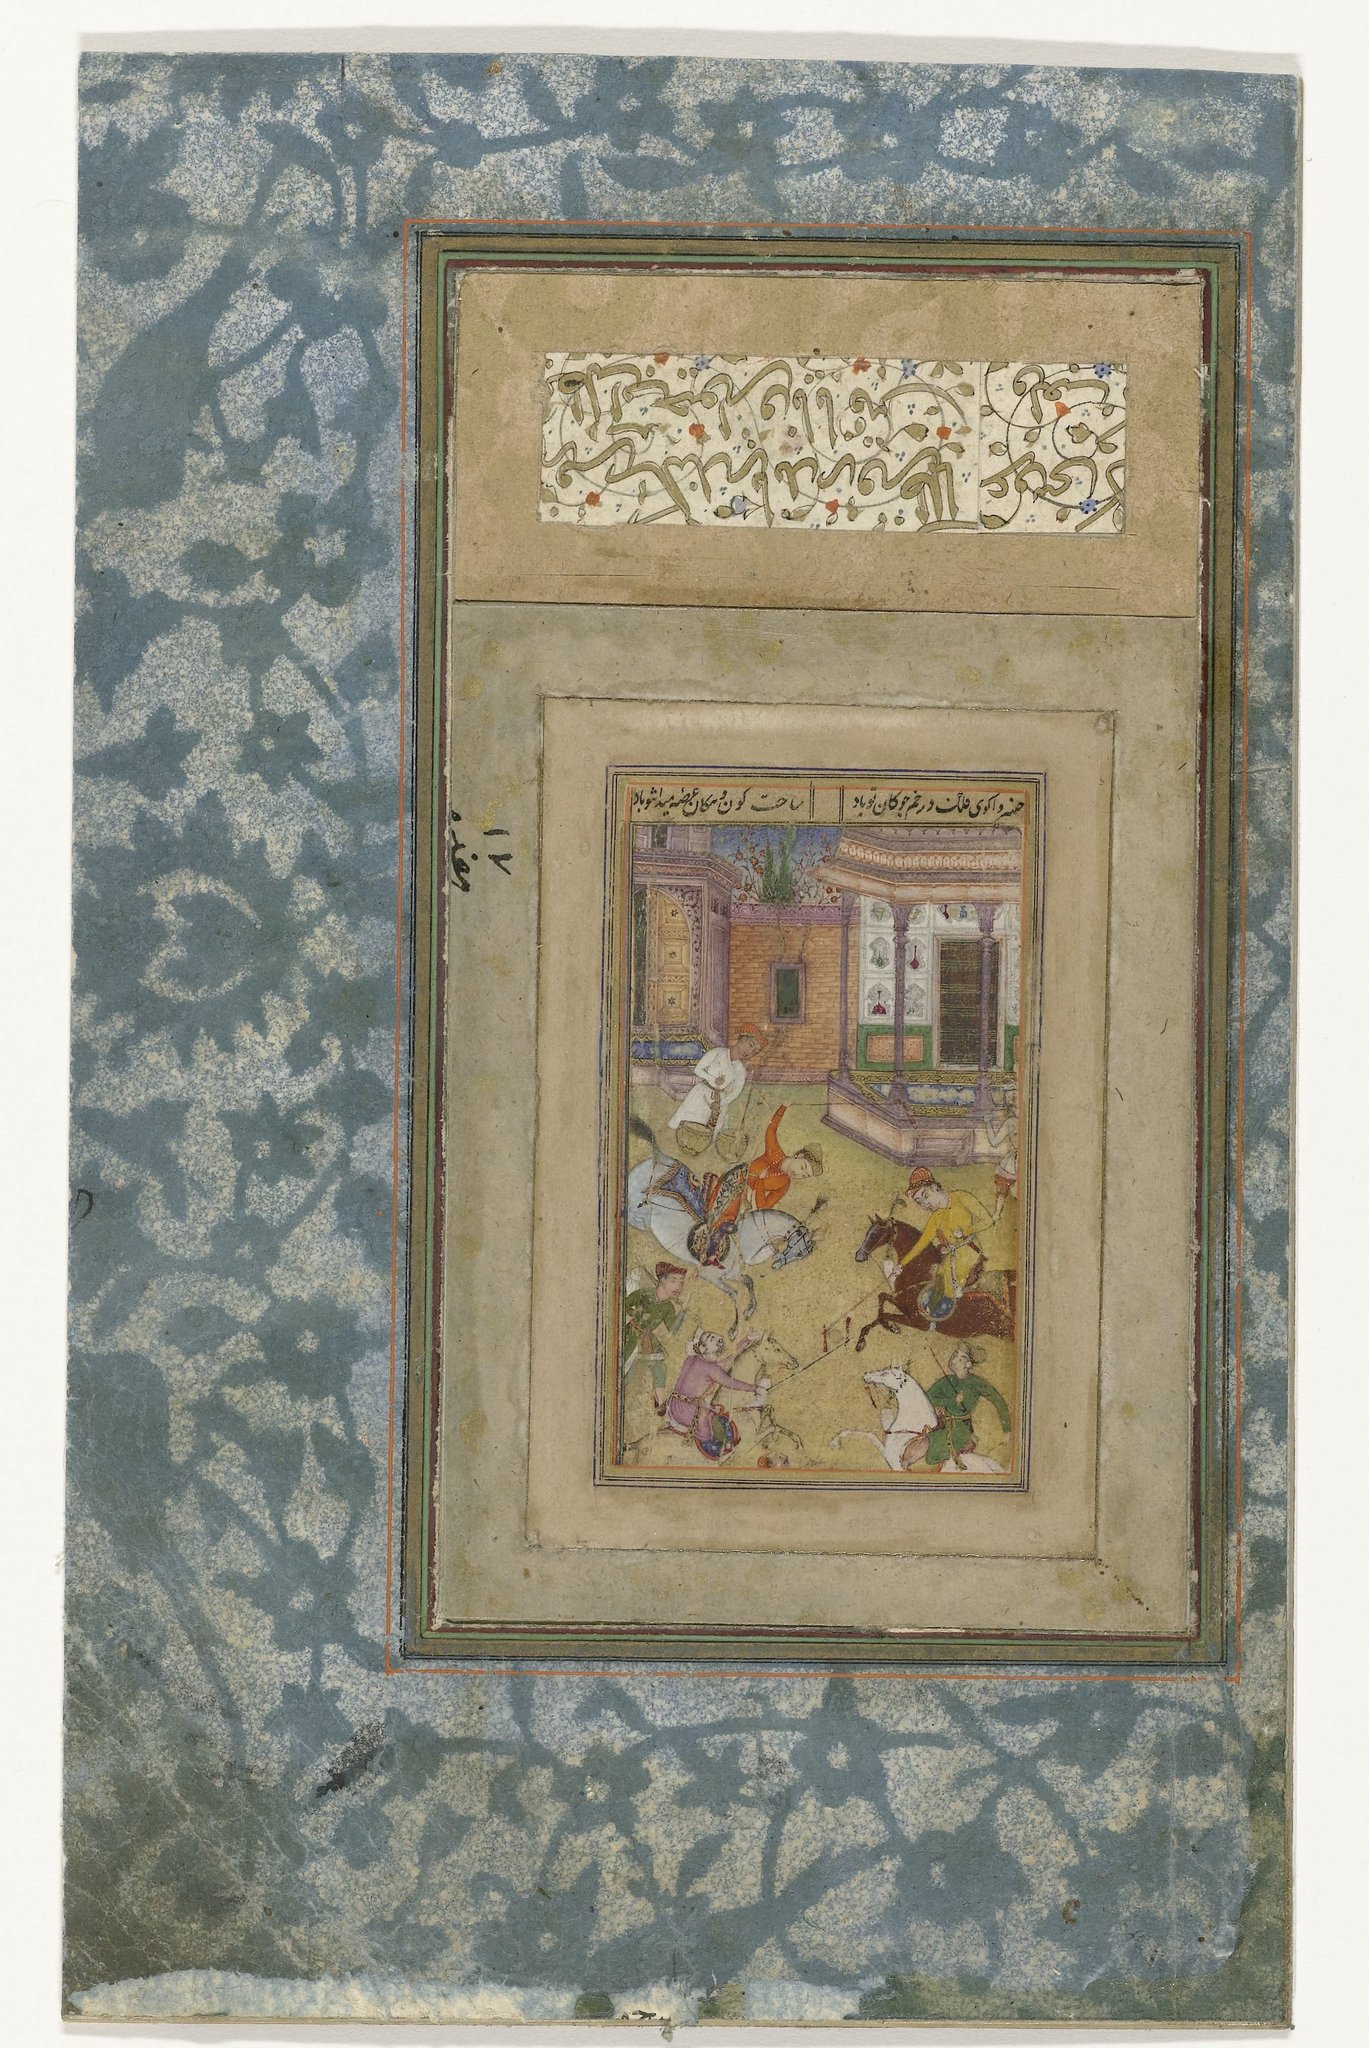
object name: drawing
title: Het polospel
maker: Anonymous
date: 1600-1625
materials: gouache, paper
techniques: brush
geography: india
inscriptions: inscription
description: Polospelers. De voorstelling ligt op de rechterkant van een blad dat met blauwe verf voorzien is van een rankenpatroon, rond de voorstelling een opgeplakte lijst van onversierd papier met daaromheen gekleurde kaderlijnen en een goudbiesje in zwarte kaderlijnen; bovenaan een rechthoek met een middenstuk waarop tegen een bloemen- en rankenmotief een in goud geschreven tekst in perzisch schrift staat.